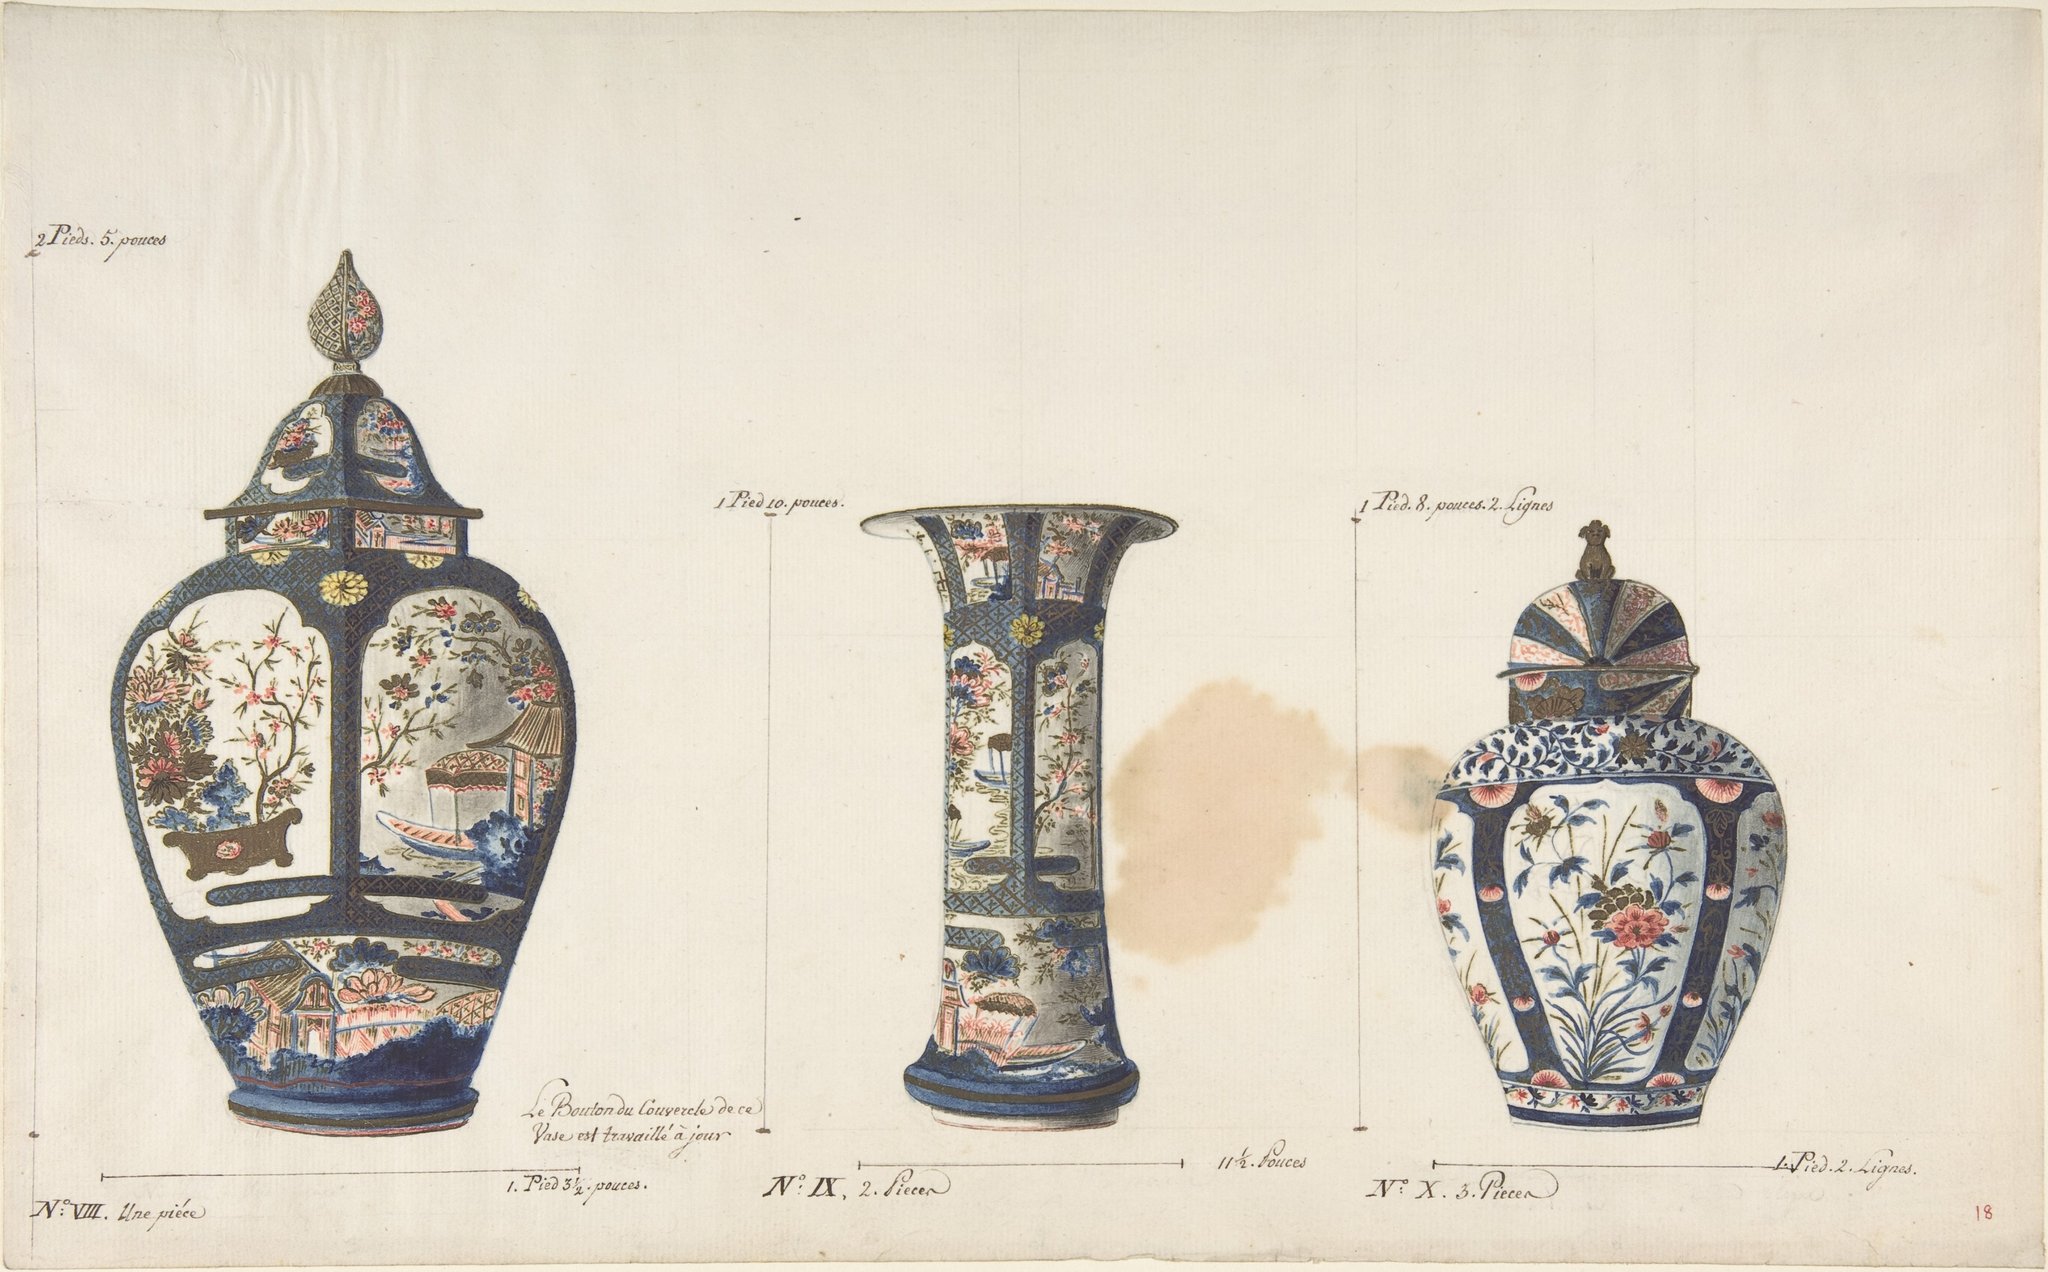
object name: drawing ornament architecture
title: Design for Three Vases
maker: anonymous, french, 18th century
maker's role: artist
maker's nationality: french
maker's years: 1700-1800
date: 1770-1785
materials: graphite, ink, watercolor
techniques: pen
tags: chinoiserie,flowers,vases